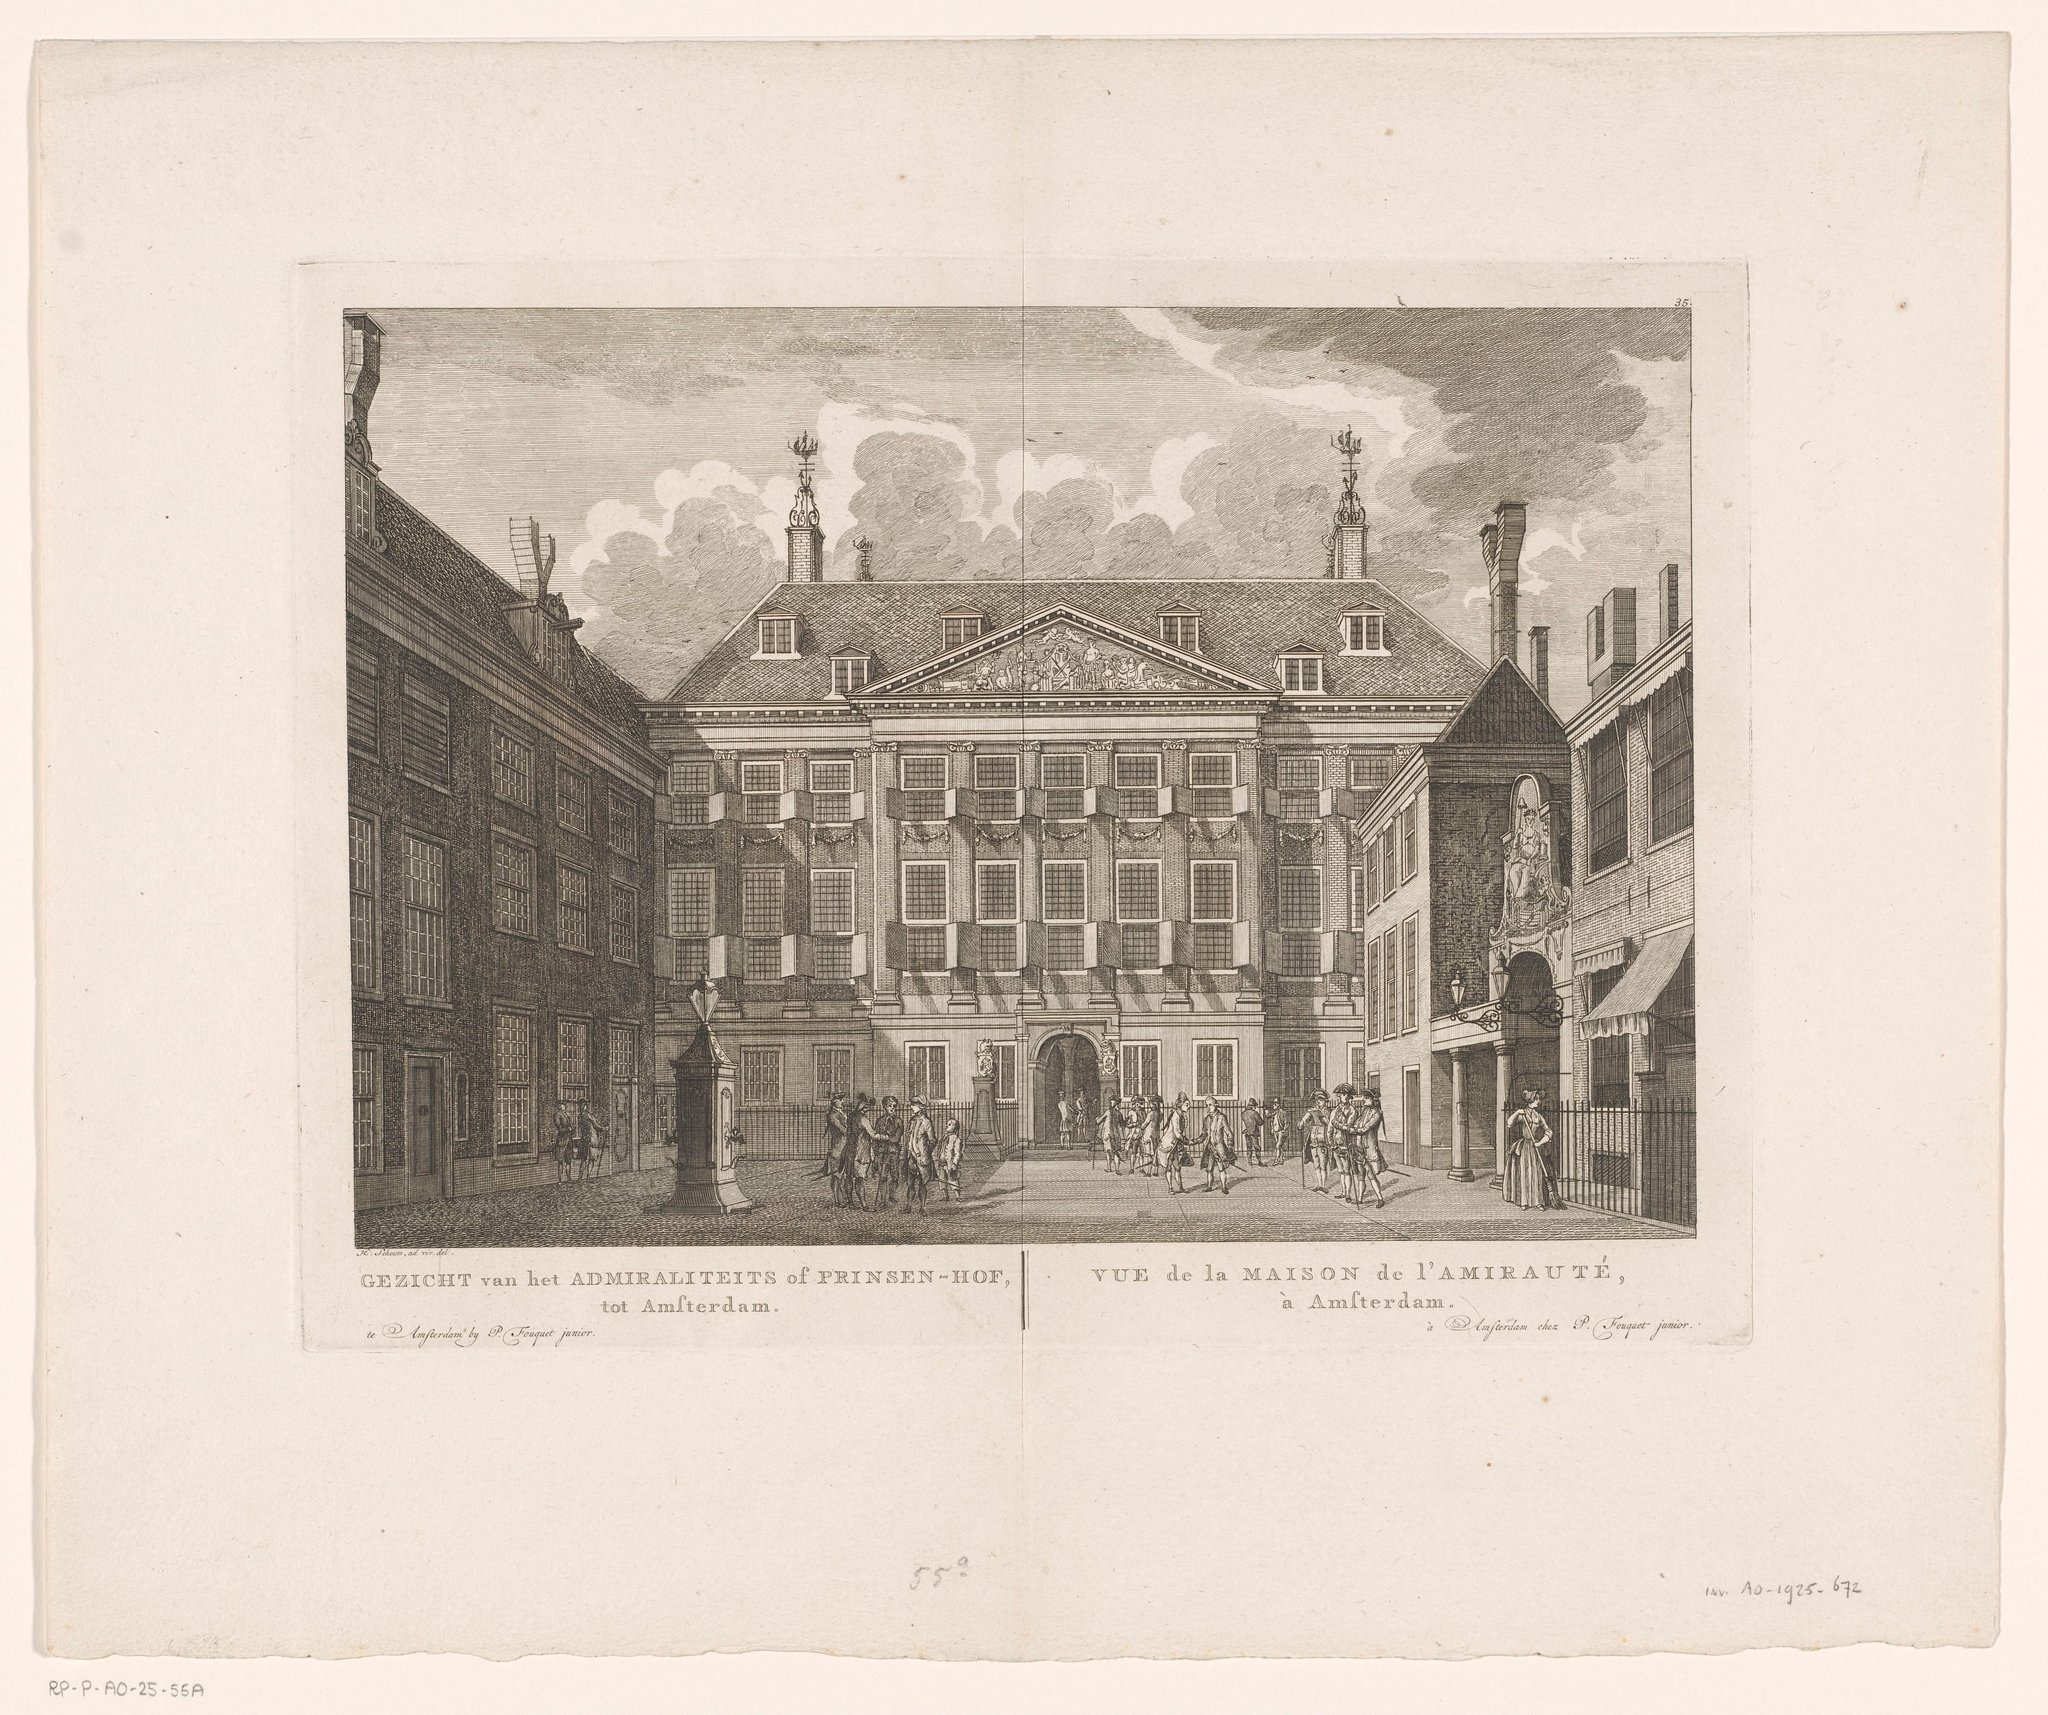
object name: print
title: Gezicht op de binnenplaats van het Prinsenhof (Admiraliteitshof) te Amsterdam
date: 1770-1783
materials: paper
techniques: engraving, etching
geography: amsterdam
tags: courtyard, exterior ~ representation of a building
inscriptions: collector's mark: Lugt 2228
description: Deze prent is ook gebruikt in de zogenaamde Atlas van Fouquet.* Pierre Fouquet gaf vanaf 1760 stadsgezichten van Amsterdam - naar tekeningen van verschillende kunstenaars, gemaakt door verschillende prentmakers - uit. Deze prenten werden aanvankelijk los of in series verkocht. Zoals toen gebruikelijk kon de koper de prenten zelf laten inbinden. Hiertoe gaf Fouquet tussen 1778 en 1783 een titelblad, plattegrond en inhoudsopgave van de tot dusver 100 uitgegeven prenten uit (1). Gezien de inhoud afhankelijk was van wat de koper had verzameld verschilt de inhoud van de verschillende bewaarde Fouquetatlassen onder deze titel sterk. Ook zijn er exemplaren bekend waar tevens andere prenten aan zijn toegevoegd. Omdat er behoefte bleek aan uitleg bij de platen werd in 1783 een nieuwe versie van de atlas uitgegeven, aangevuld met tekst en twee prenten. De aangegeven volgorde veranderde maar de platen van de al eerder uitgegeven prenten bleven ongewijzigd. Deze uitgave werd in opdracht van Fouquet gedrukt bij Daniël Jean Changuion en Petrus den Hengst (2). Een tiental platen werd bijgewerkt en verscheen, met nieuw impressum, in het vervolg van Wagenaars geschiedenis van Amsterdam, uitgeven door Petrus Conradi en Folkert van der Plaats (3). Een aantal jaar na het overlijden van Fouquet kwam Evert Maaskamp met een nieuwe uitgave van de atlas, met verbeterde tekst en toevoeging van twee prenten. Op alle platen verwijderde hij het oude en liet hij zijn eigen impressum zetten (4). De huidige staat van de prent komt voor in exemplaren van de onder (1) en (2) genoemde werken. * Onder de Atlas van Fouquet of Fouquetatlas verstaan we de hieronder vermelde publicaties (1), (2) en (4). (1). Afbeeldingen van de wyd-vermaarde koopstad Amsterdam benevens des zelvs voornaamste gebouwen en gezigten alle naar het leeven getekend / Receuil des edifices les plus considerables et des plus belles vues, de la fameuse ville d'Amsterdam, dessinées d'après nature. Amsterdam: Pierre Fouquet, 1778-1783. (2). Nieuwe atlas, van de voornaamste gebouwen en gezigten der stad Amsterdam, met derzelver beknopte beschryvingen. 2 delen. Amsterdam: Daniël Jean Changuion en Petrus den Hengst [in opdracht van Pierre Fouquet], 1783. (3). Stijl, Simon. Amsterdam, in zyne geschiedenissen, voorregten, koophandel, gebouwen, kerkenstaat, schoolen, schutterye, gilden en regeeringe, beschreeven. Om te dienen ten vervolge op het werk van Jan Wagenaar (…). 10 delen. Amsterdam en Harlingen: Petrus Conradi en Folkert van der Plaats, 1788-1801. (4). Nieuwe atlas, van de voornaamste gebouwen en gezigten der stad Amsterdam. Met derzelver beknopte beschryvingen. Amsterdam: Evert Maaskamp, 1805. * Het aantal vermelde staten is gebaseerd op het aantal gevonden staten. Mogelijk zijn er meer staten van deze prent.